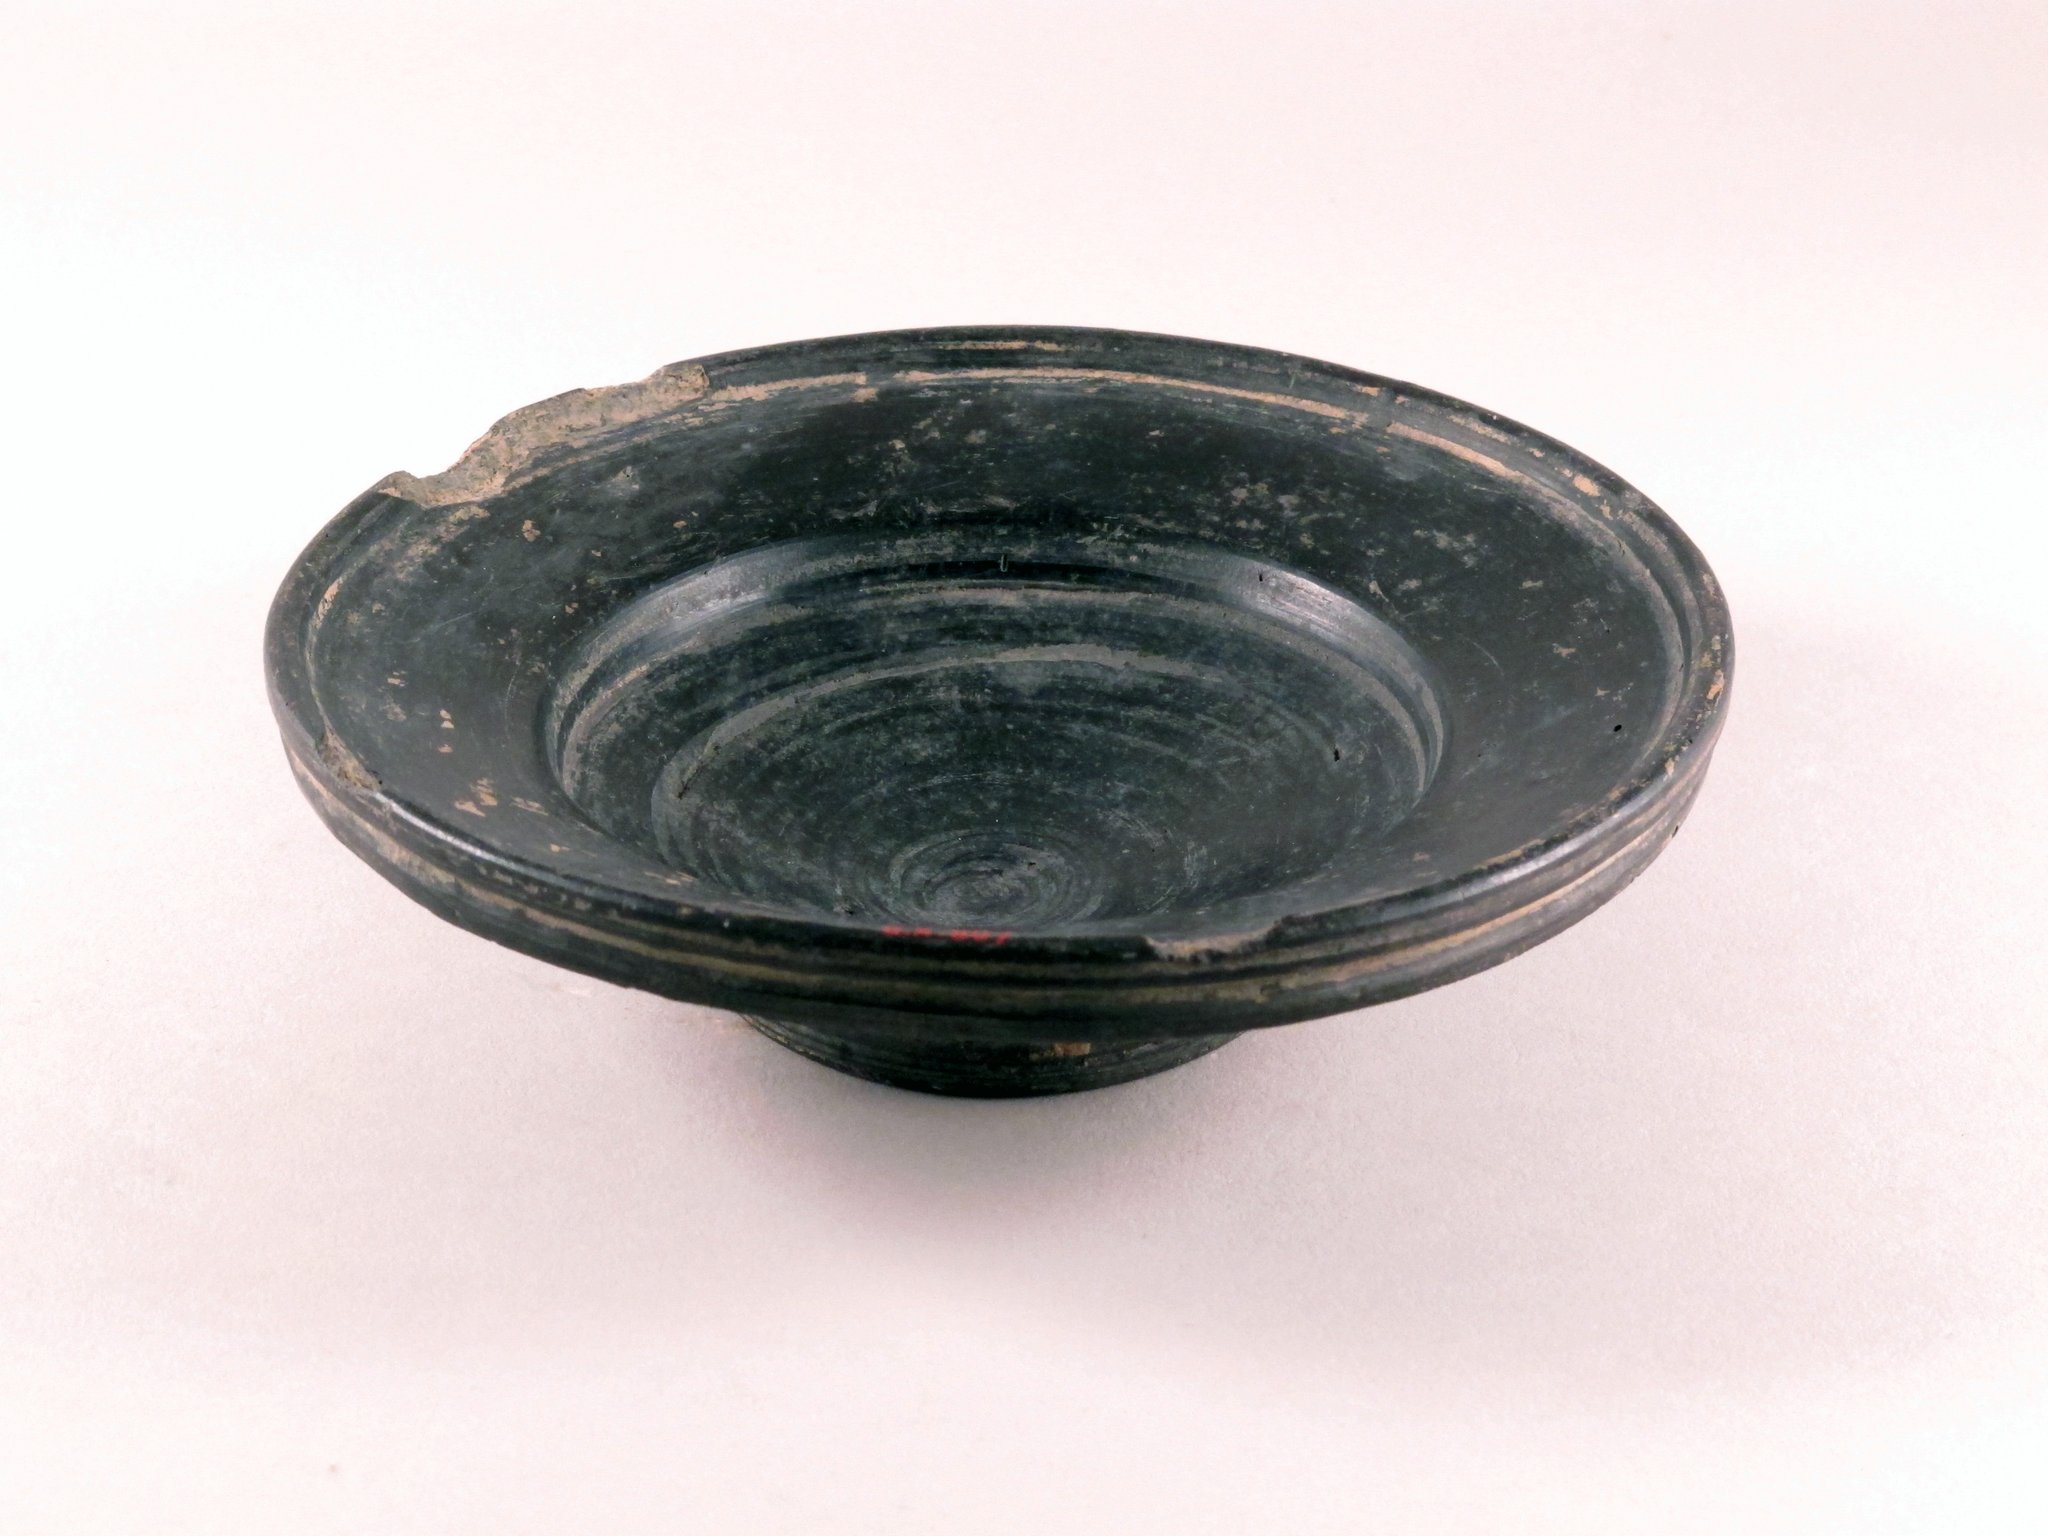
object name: dish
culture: etruscan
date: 550 BCE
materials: terracotta